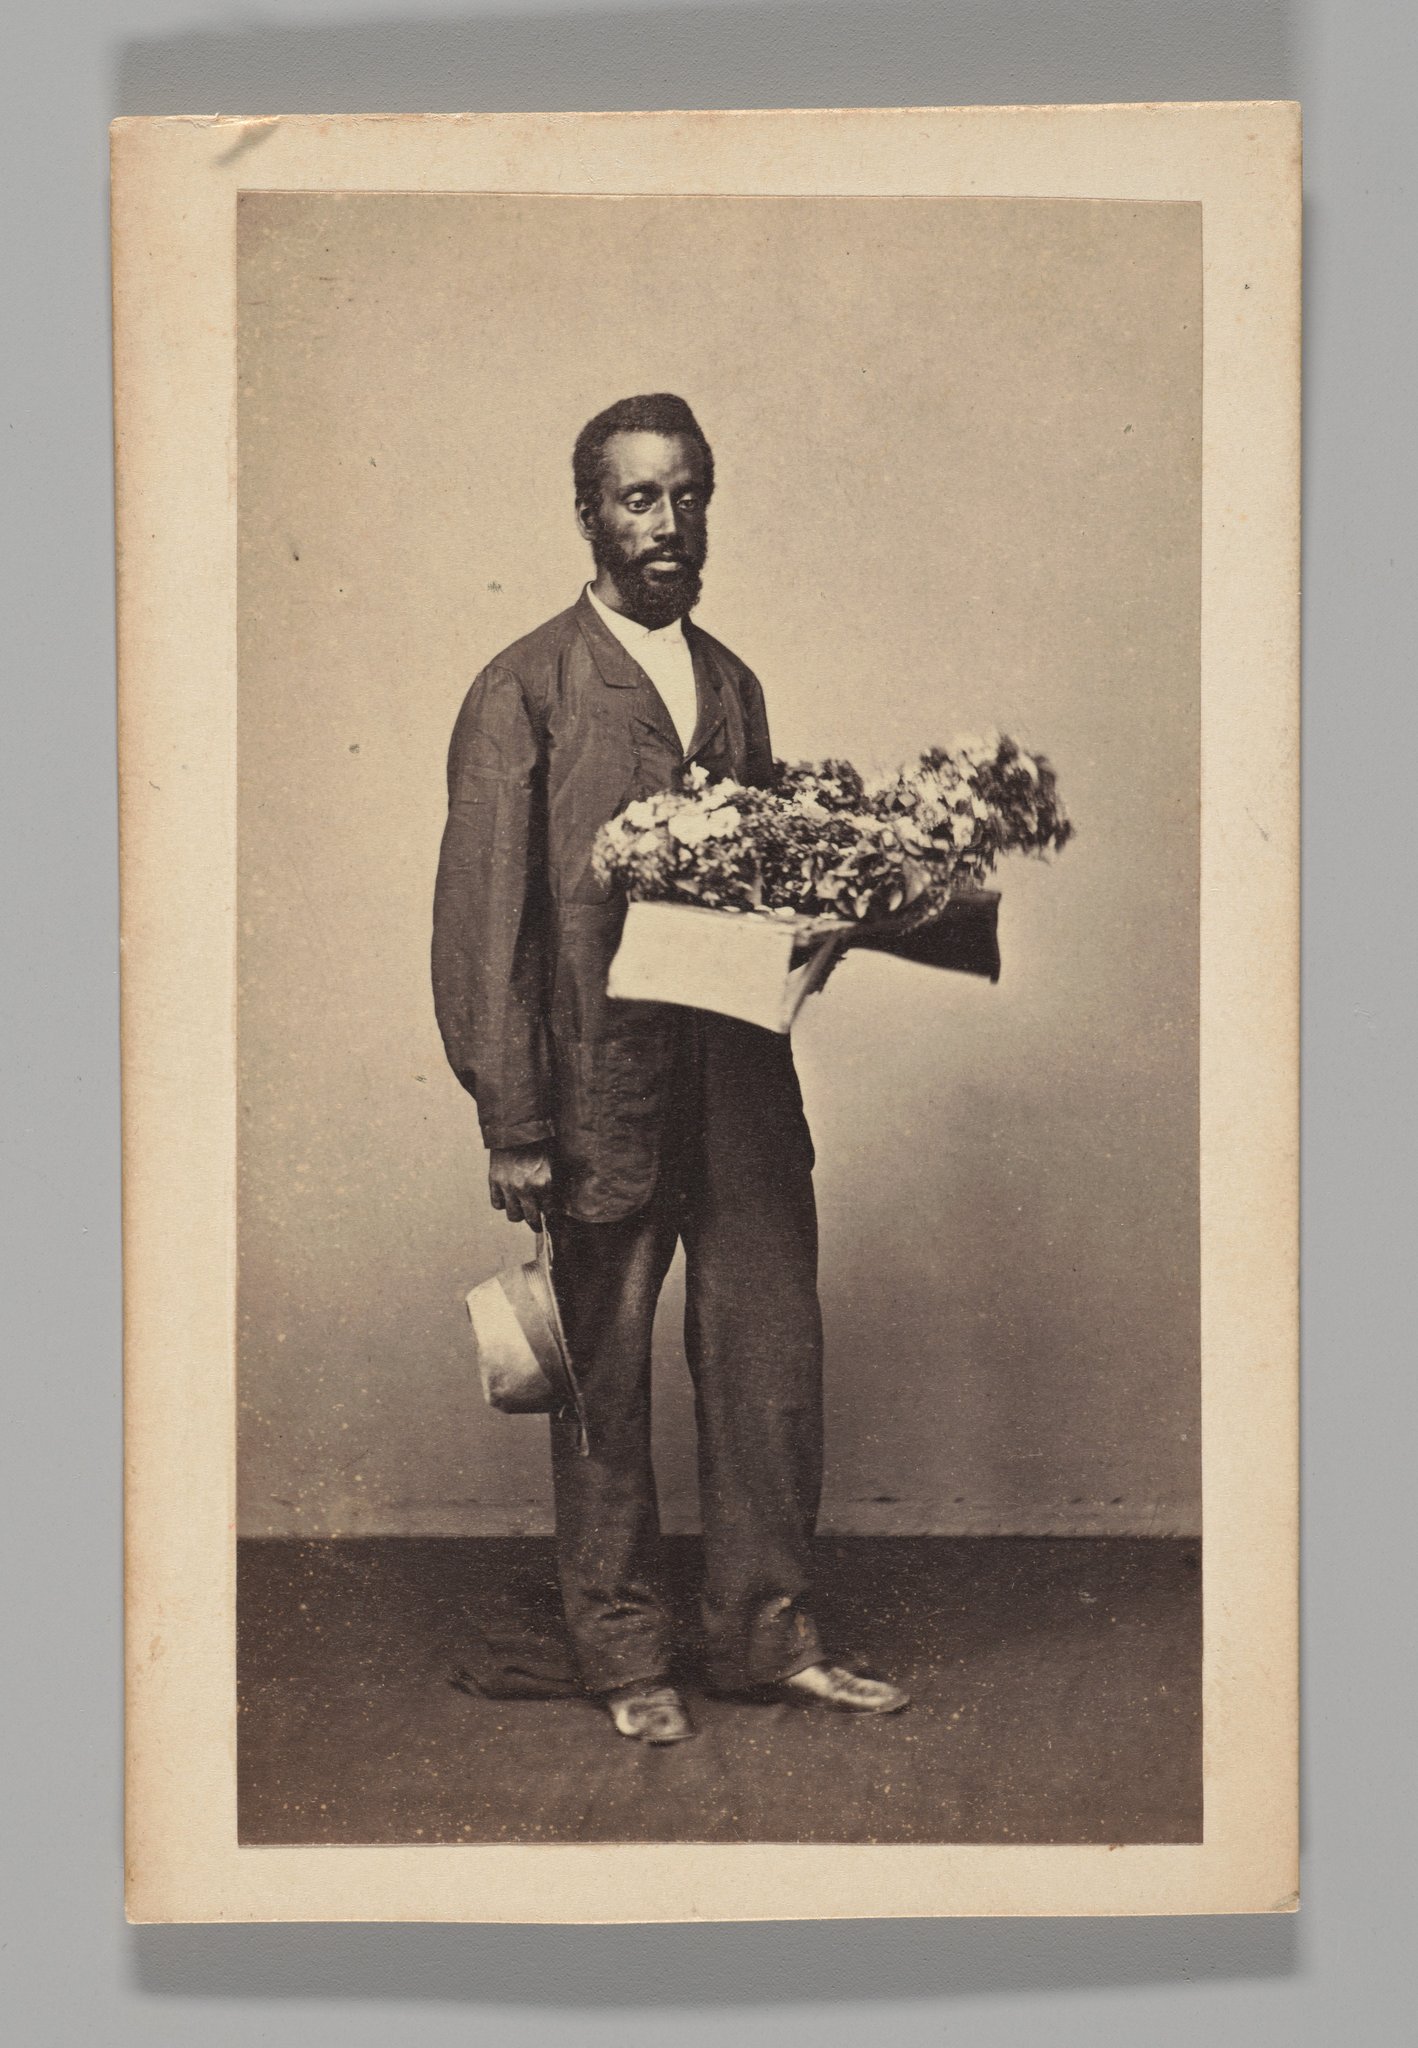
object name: carte de visite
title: [Studio Portrait: Male Street Vendor Holding Box of Flowers, Brazil]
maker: Anonymous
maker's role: artist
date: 1864-1866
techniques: albumen silver print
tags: men,portraits